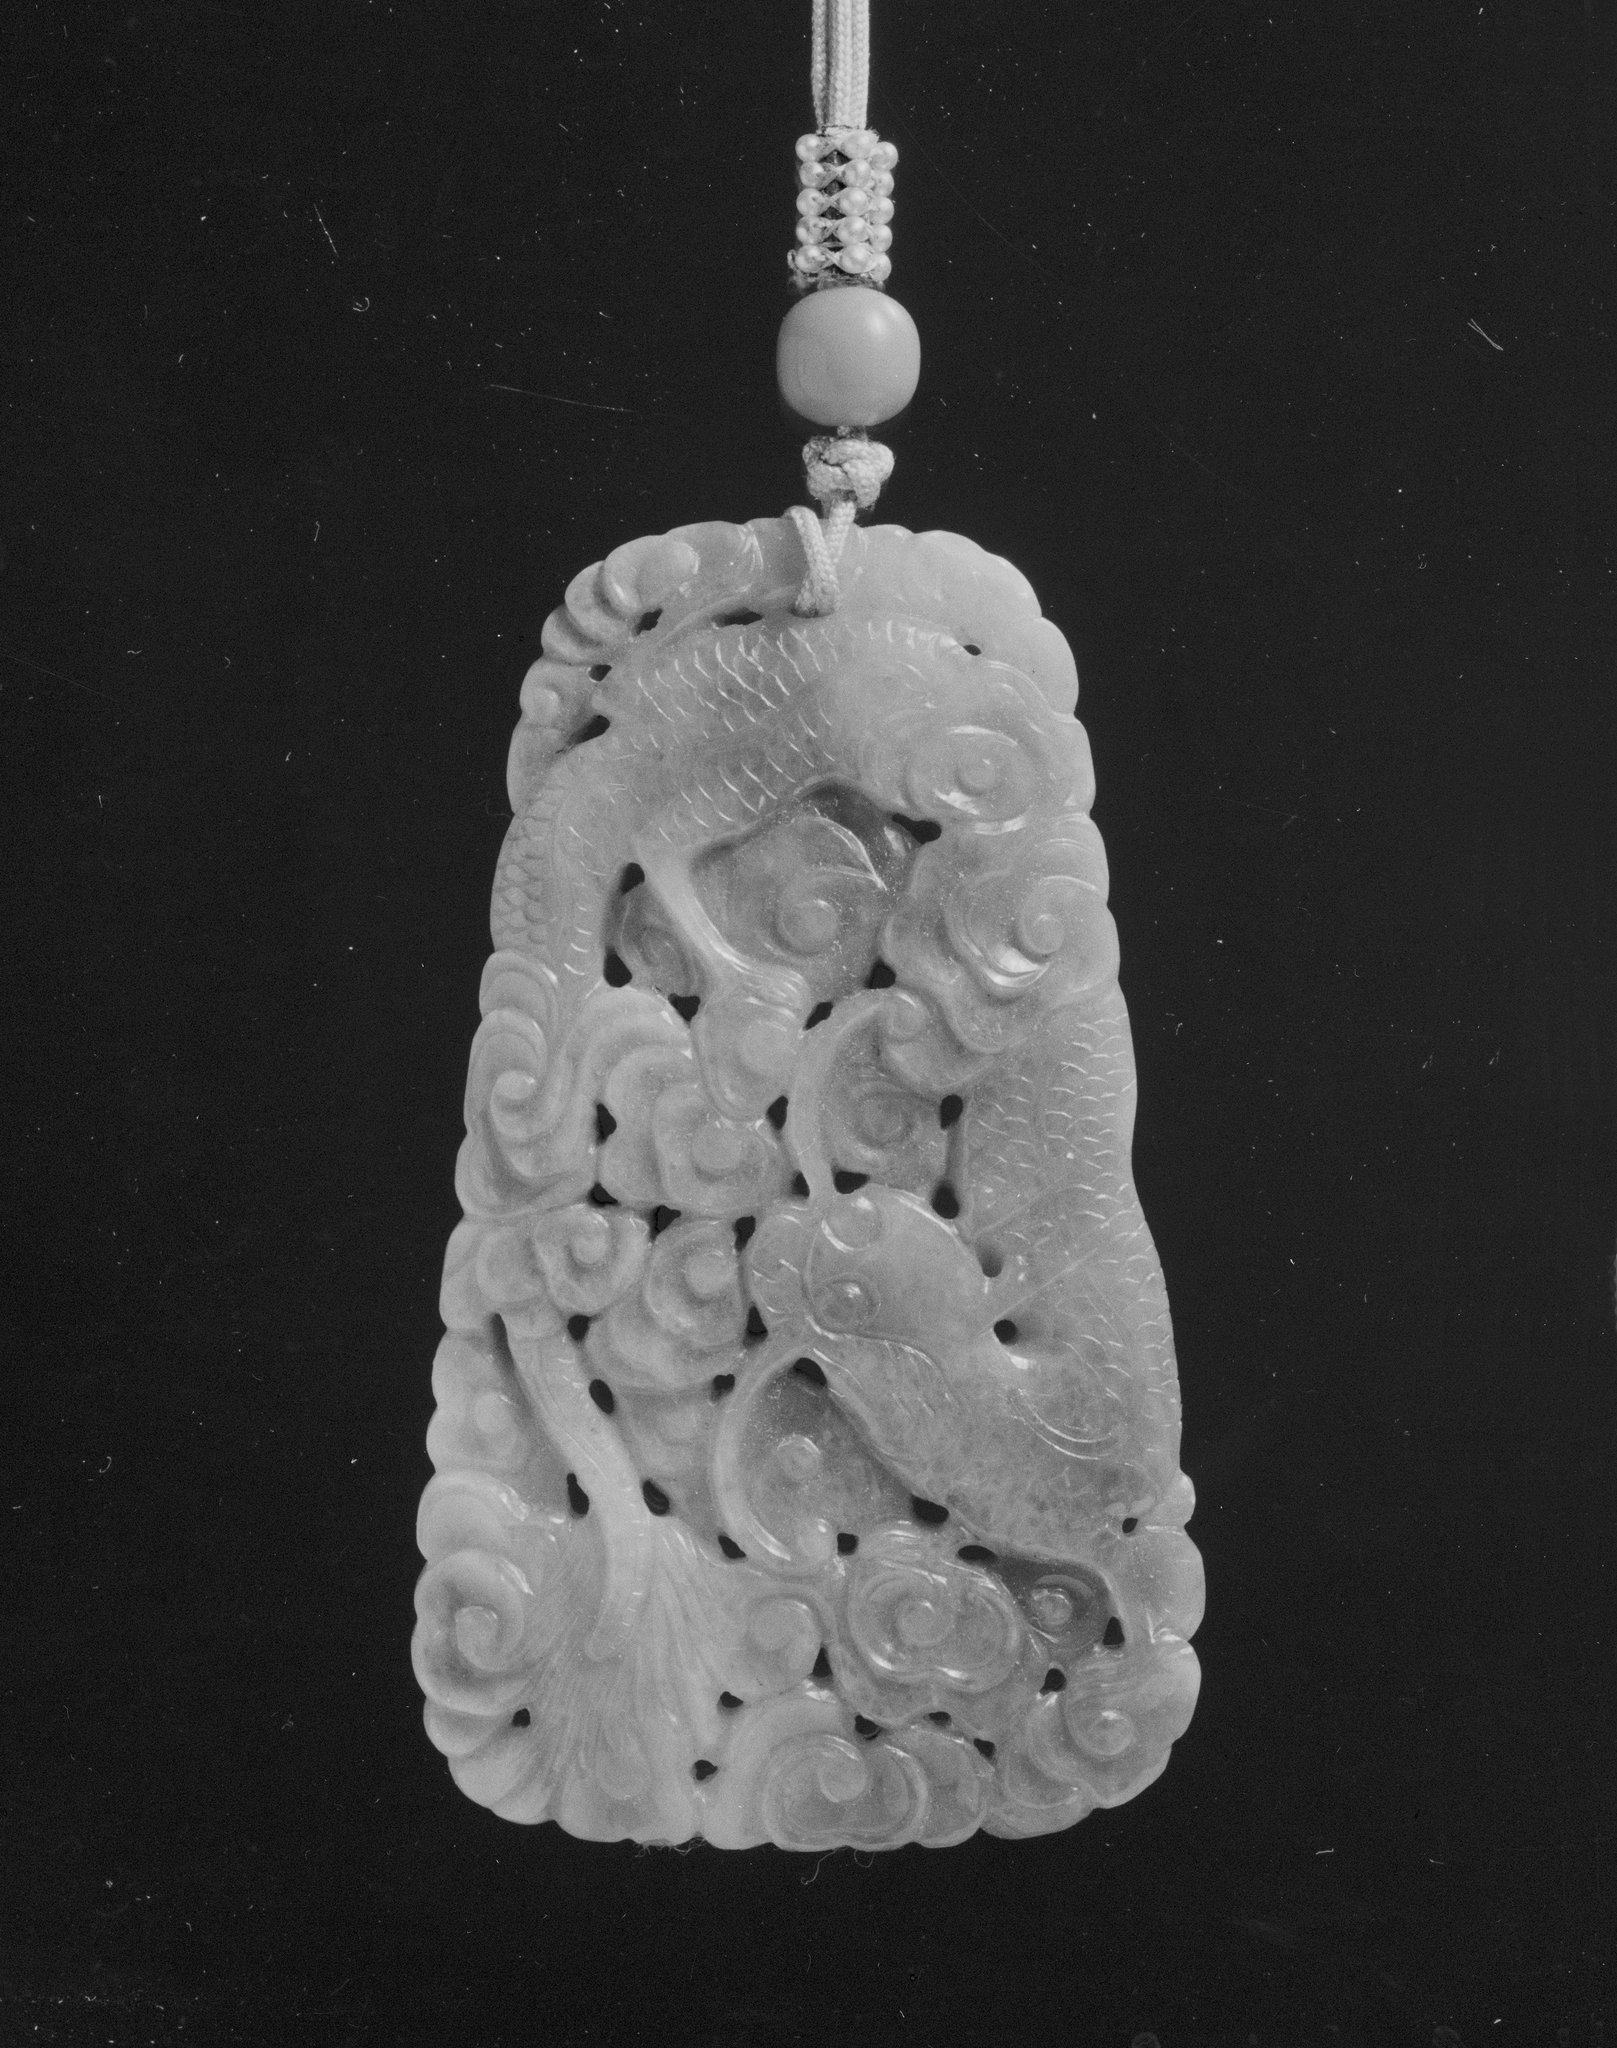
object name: pendant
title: Pendant with dragon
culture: chinese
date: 1901-2000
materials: jade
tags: dragons